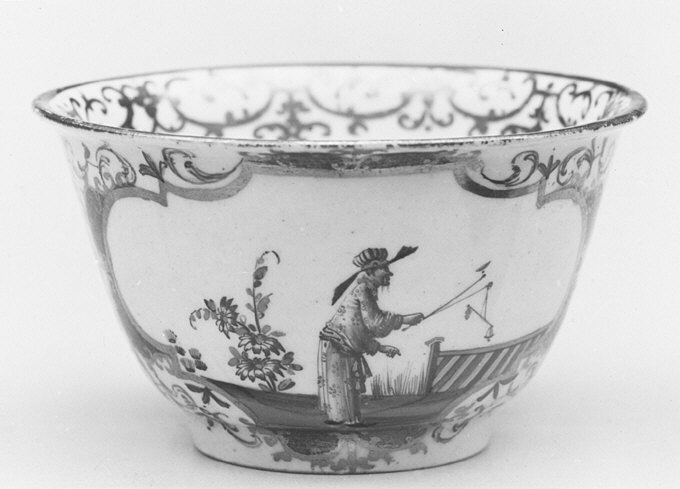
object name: cup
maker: meissen manufactory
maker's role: manufactory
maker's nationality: german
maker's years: 1710-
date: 1725-1730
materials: hard paste porcelain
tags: men,flowers